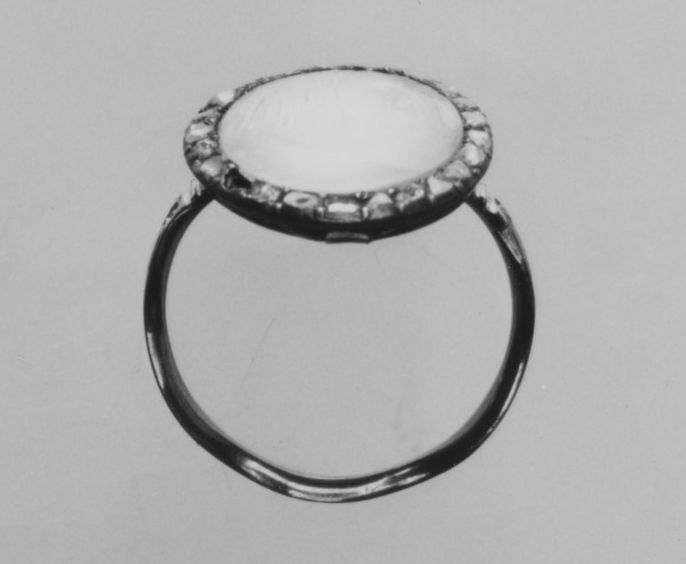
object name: ring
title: Mourning Ring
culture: american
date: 1762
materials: enamel, glass, gold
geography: united states